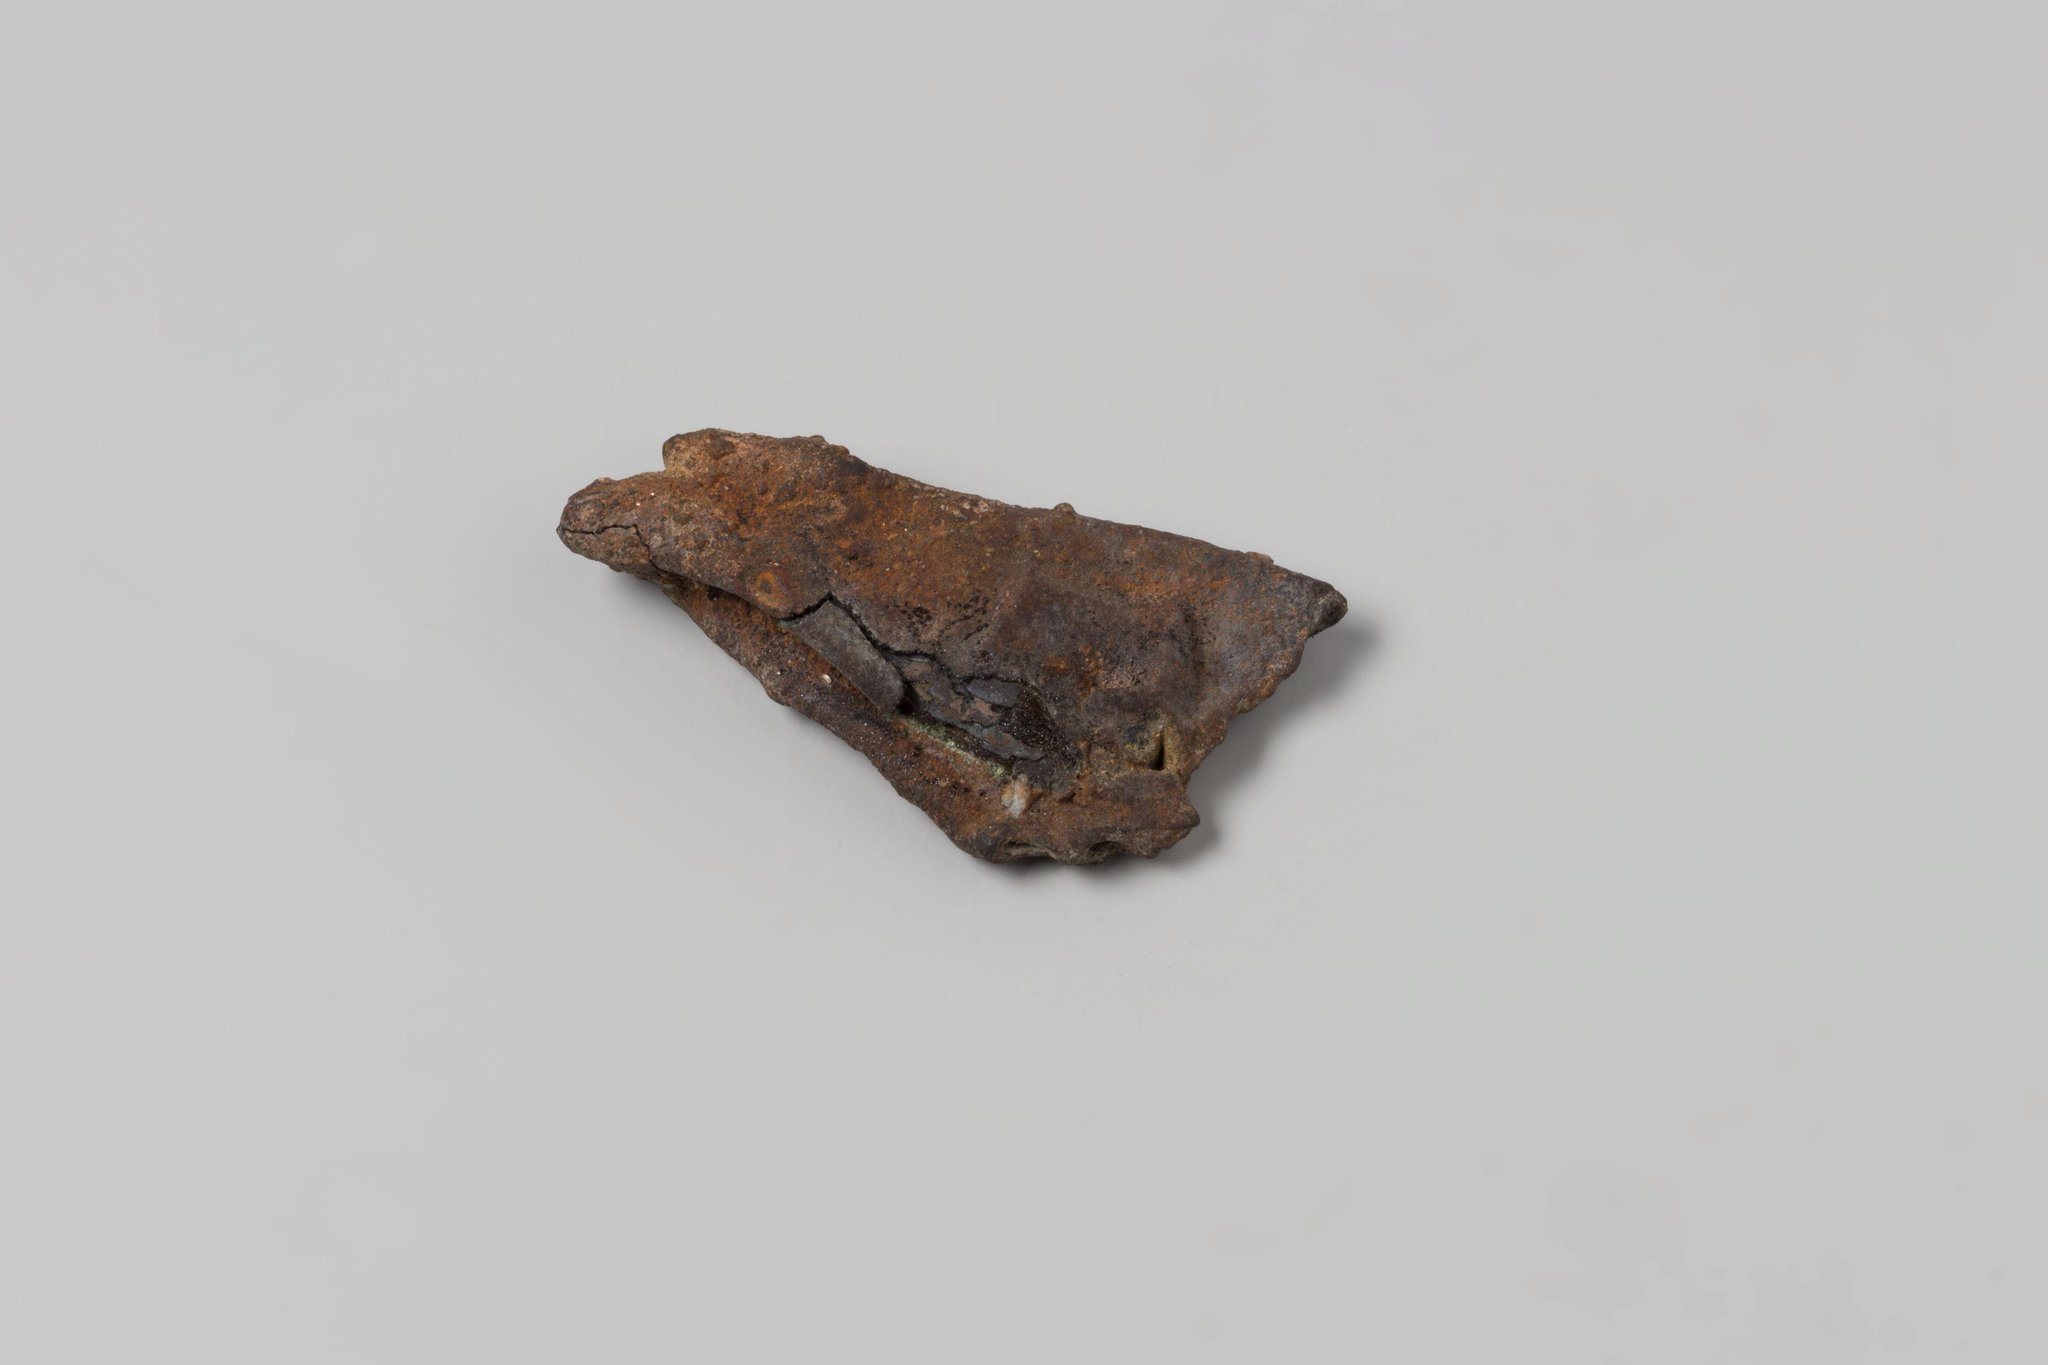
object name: fragment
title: Fragment tin uit het wrak van de Oost-Indiëvaarder Hollandia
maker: Anonymous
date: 1700-1743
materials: tin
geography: netherlands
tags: verenigde oostindische compagnie, hollandia (schip), annet